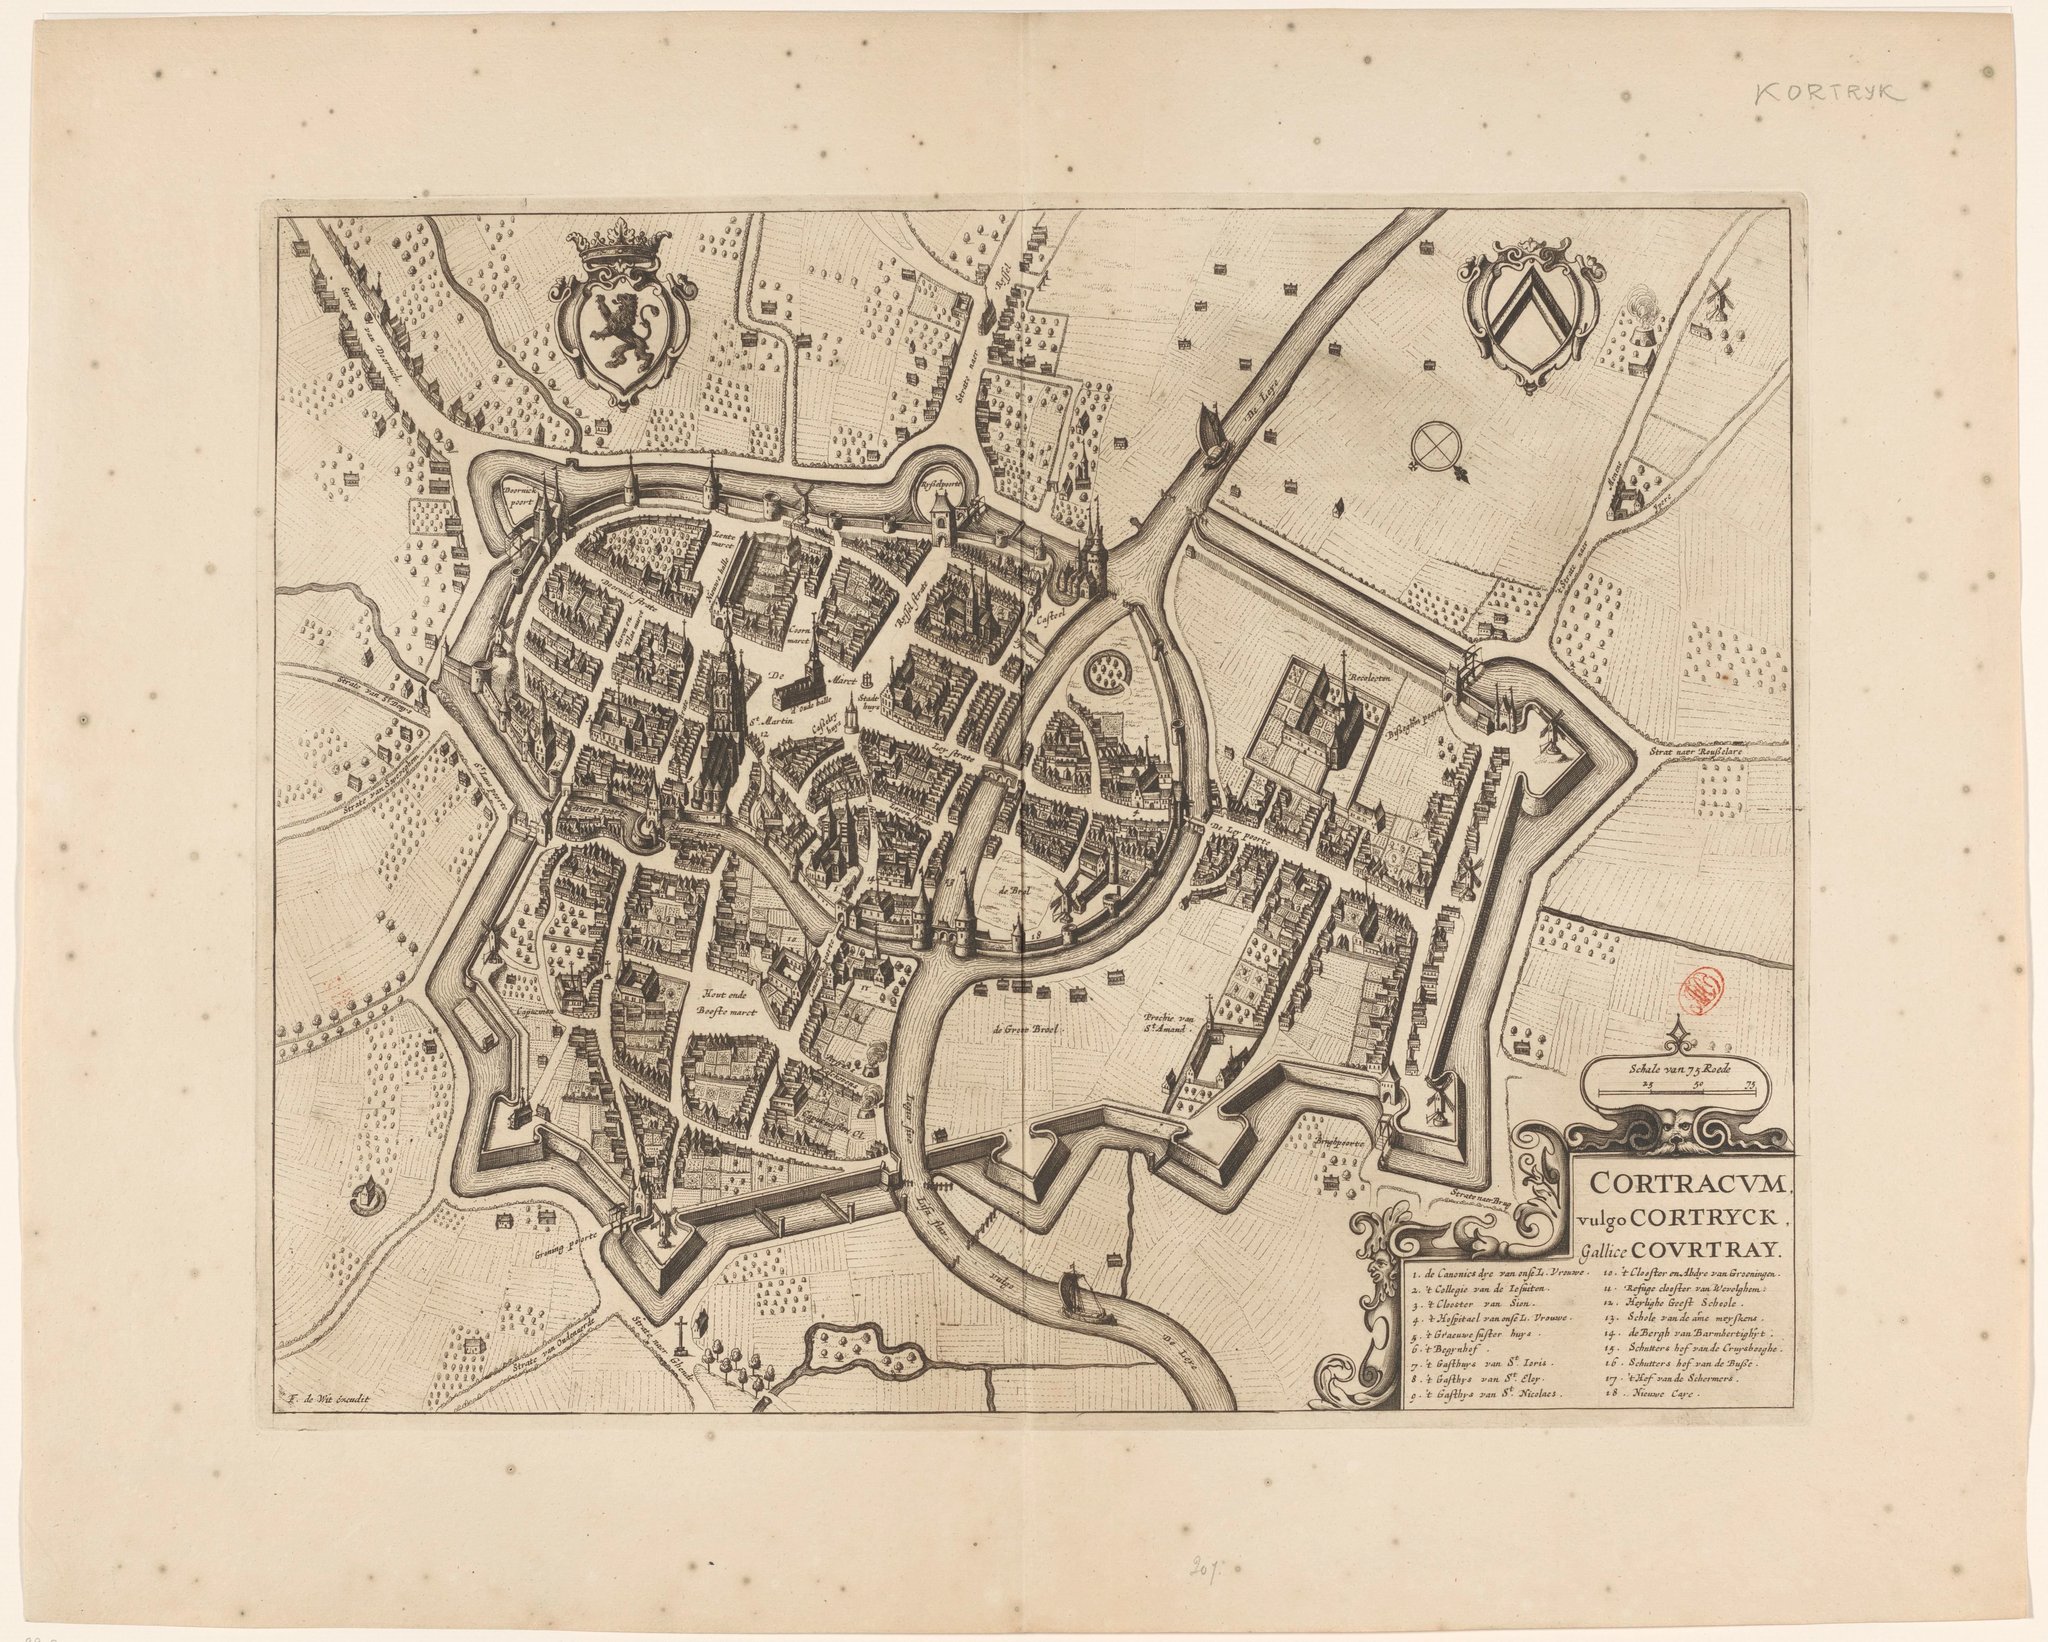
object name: area plan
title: Cortracum, vulgo Cortryck, Gallice Courtray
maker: Anonymous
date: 1657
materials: paper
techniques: engraving, etching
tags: coat of arms (as symbol of the state, etc.) (+ city; municipal), fortified city, maps of cities, coat of arms (as symbol of the state, etc.) (+ province; provincial)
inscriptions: collector's mark: Lugt 195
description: Prent ook gebruikt in: Theatrum ichnographicum omnium urbium et praecipuorum oppidorum Belgicarum XVII Provinciarum (…). Amsterdam: Frederik de Wit, ca. 1700-1710. En in: Aa, Pieter van der. La galerie agreable du monde (…). 66 delen. Leiden: Pieter van der Aa, 1728, dl. 13.